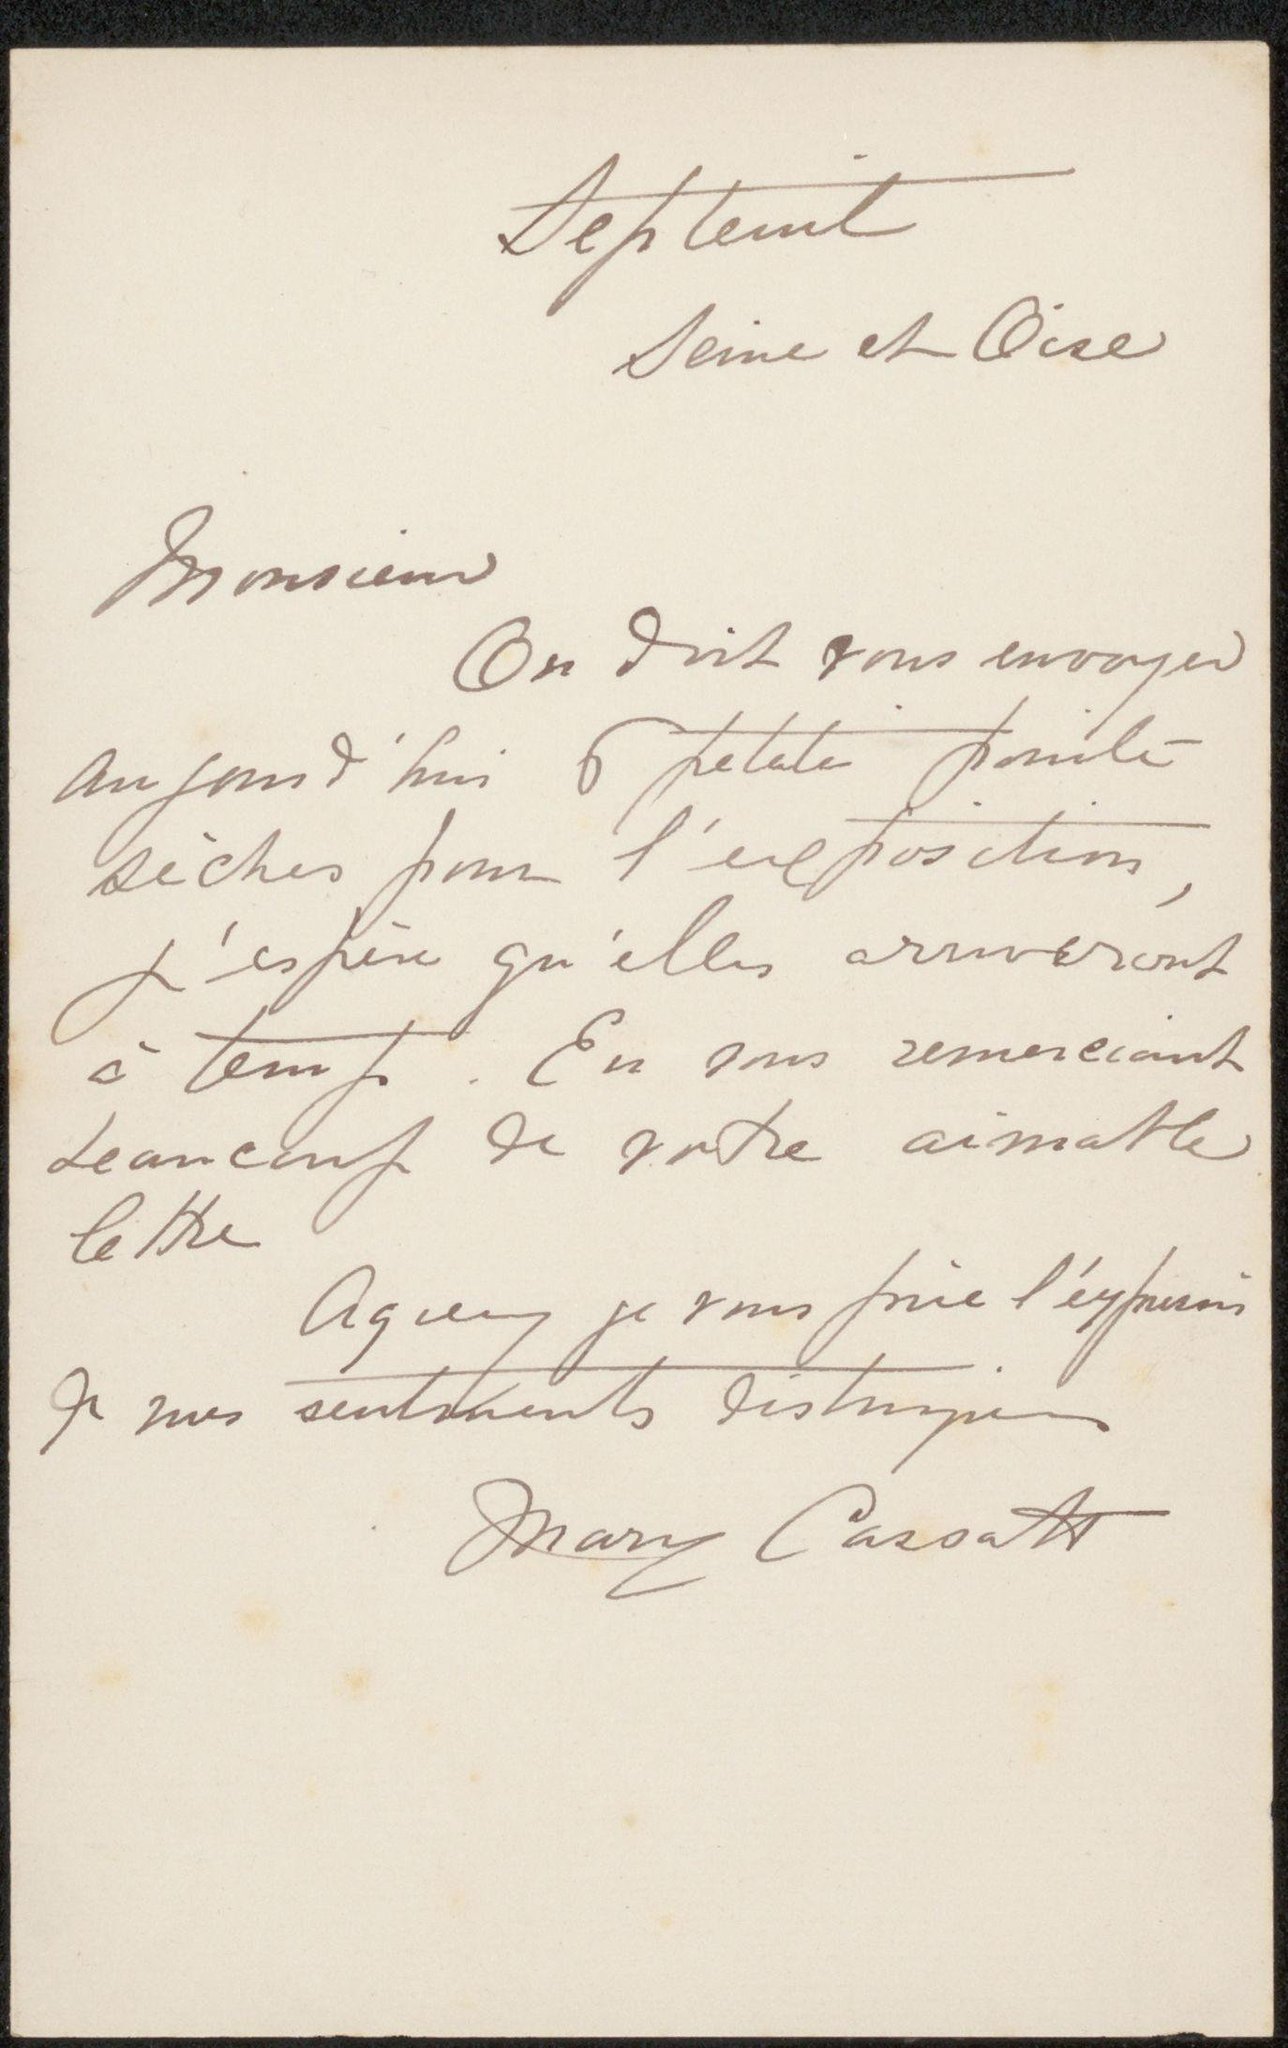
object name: letter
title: Brief aan Philip Zilcken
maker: mary cassatt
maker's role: print maker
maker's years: 1844-1926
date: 1854-1926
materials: ink, paper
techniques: pen, writing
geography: septeuil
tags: the hague, painter, draughtsman, philip zilcken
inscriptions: collector's mark: ‘RPK’, watermark